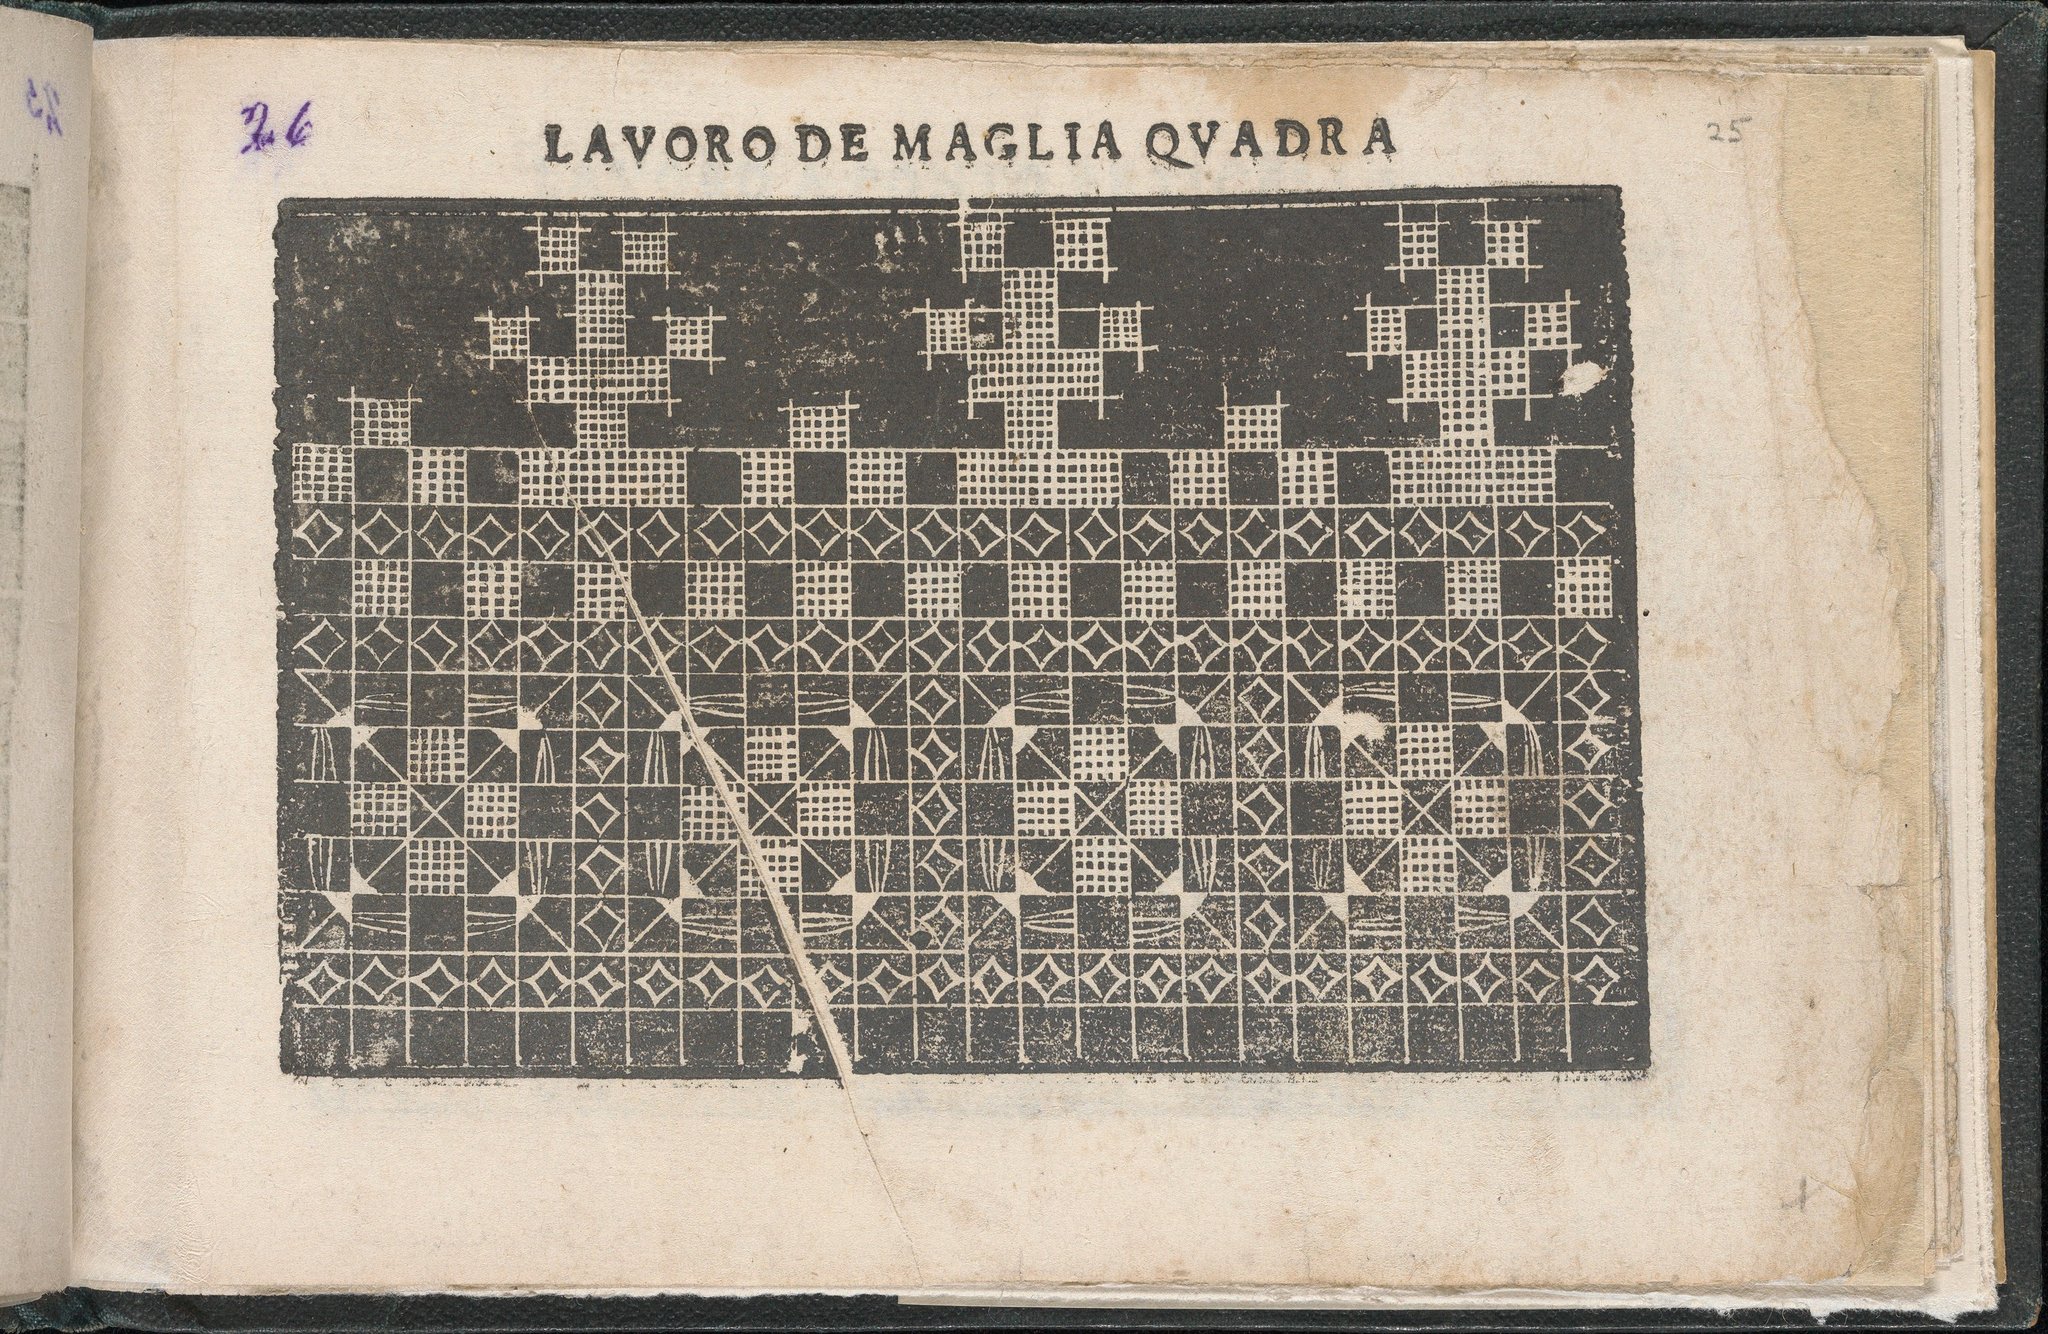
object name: book print ornament architecture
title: Gemma pretiosa della virtuose donne, page 25 (recto)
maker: isabella catanea parasole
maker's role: designer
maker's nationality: italian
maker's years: 1565-1625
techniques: woodcut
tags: ornament